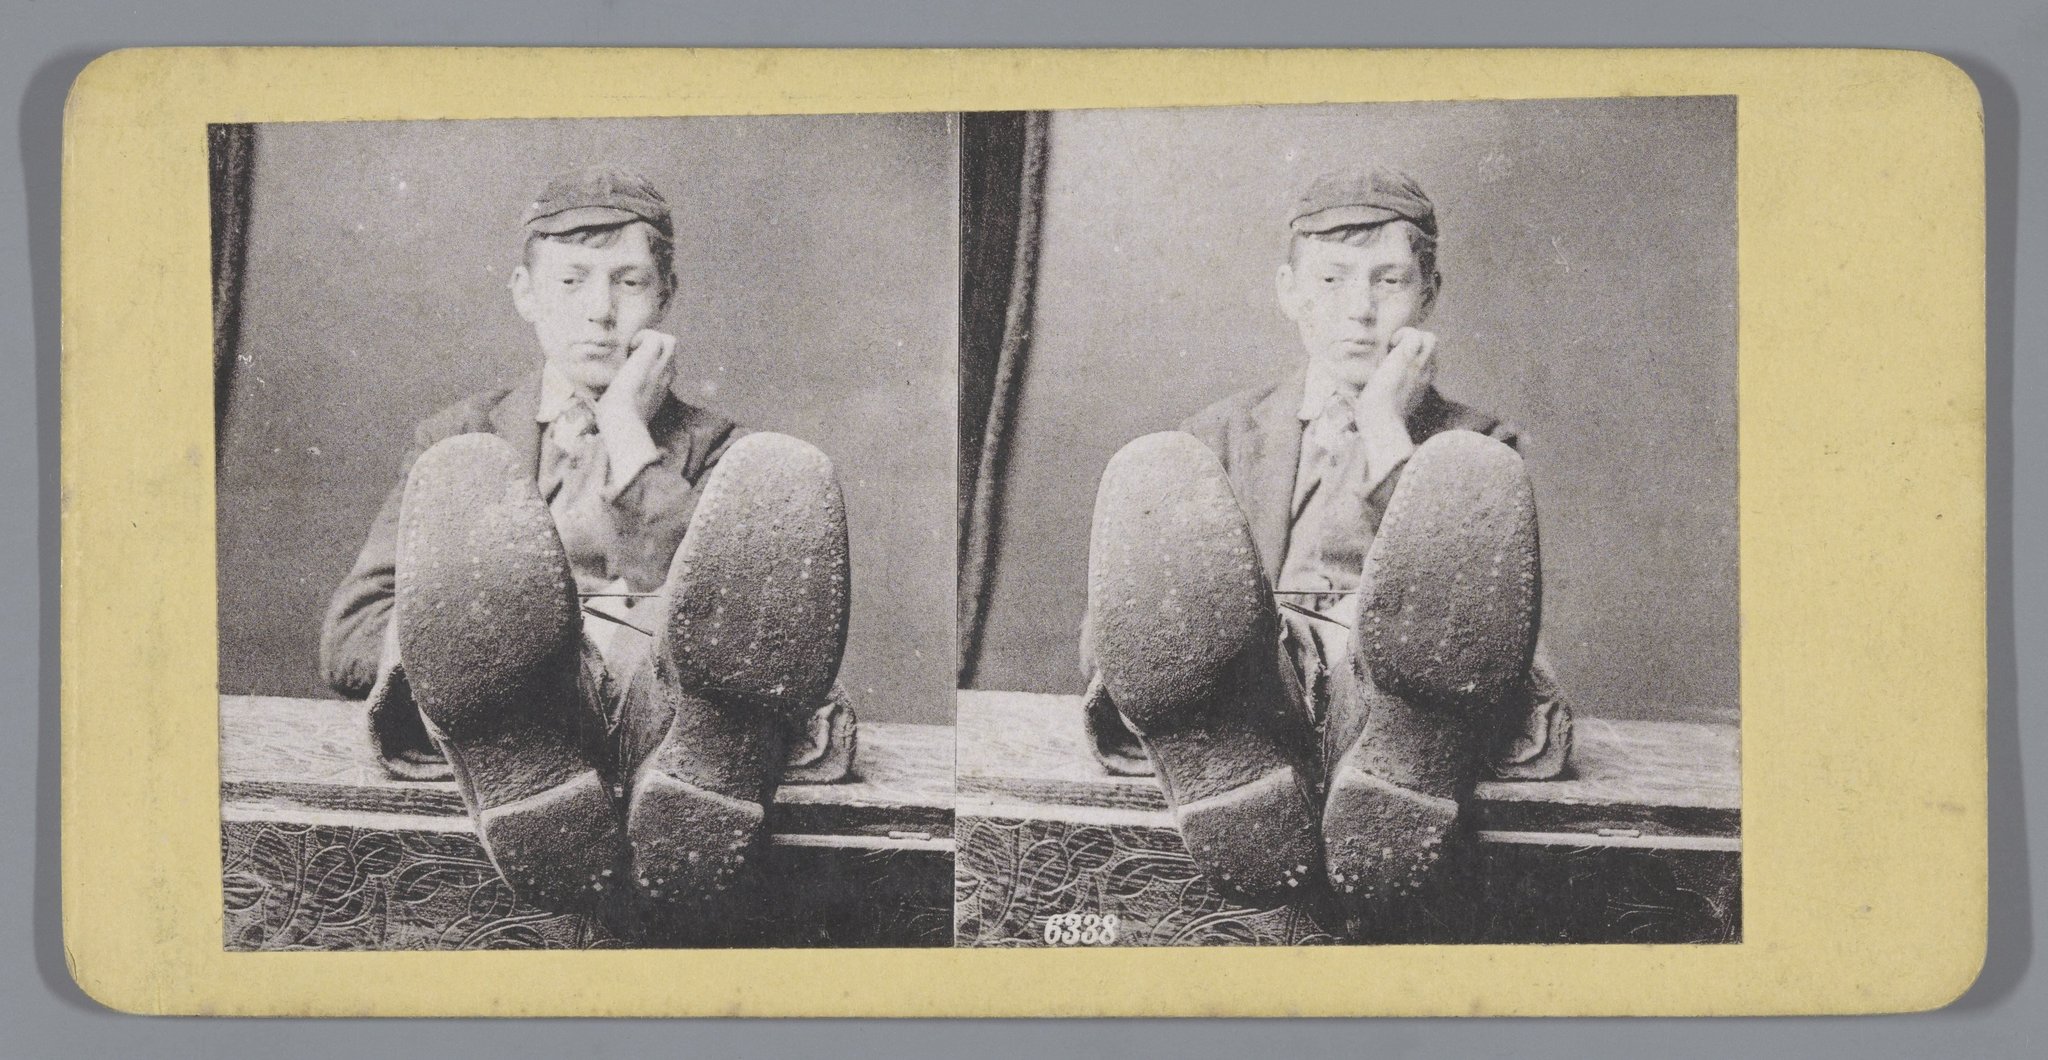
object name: photomechanical print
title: "Pim, bekend figuur in Amsterdam"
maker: Anonymous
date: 1870-1900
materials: cardboard, paper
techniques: photograph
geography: netherlands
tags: boy (child between toddler and youth), shoes, sandals, amsterdam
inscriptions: number: ‘6338’, inscription: ‘1ct’